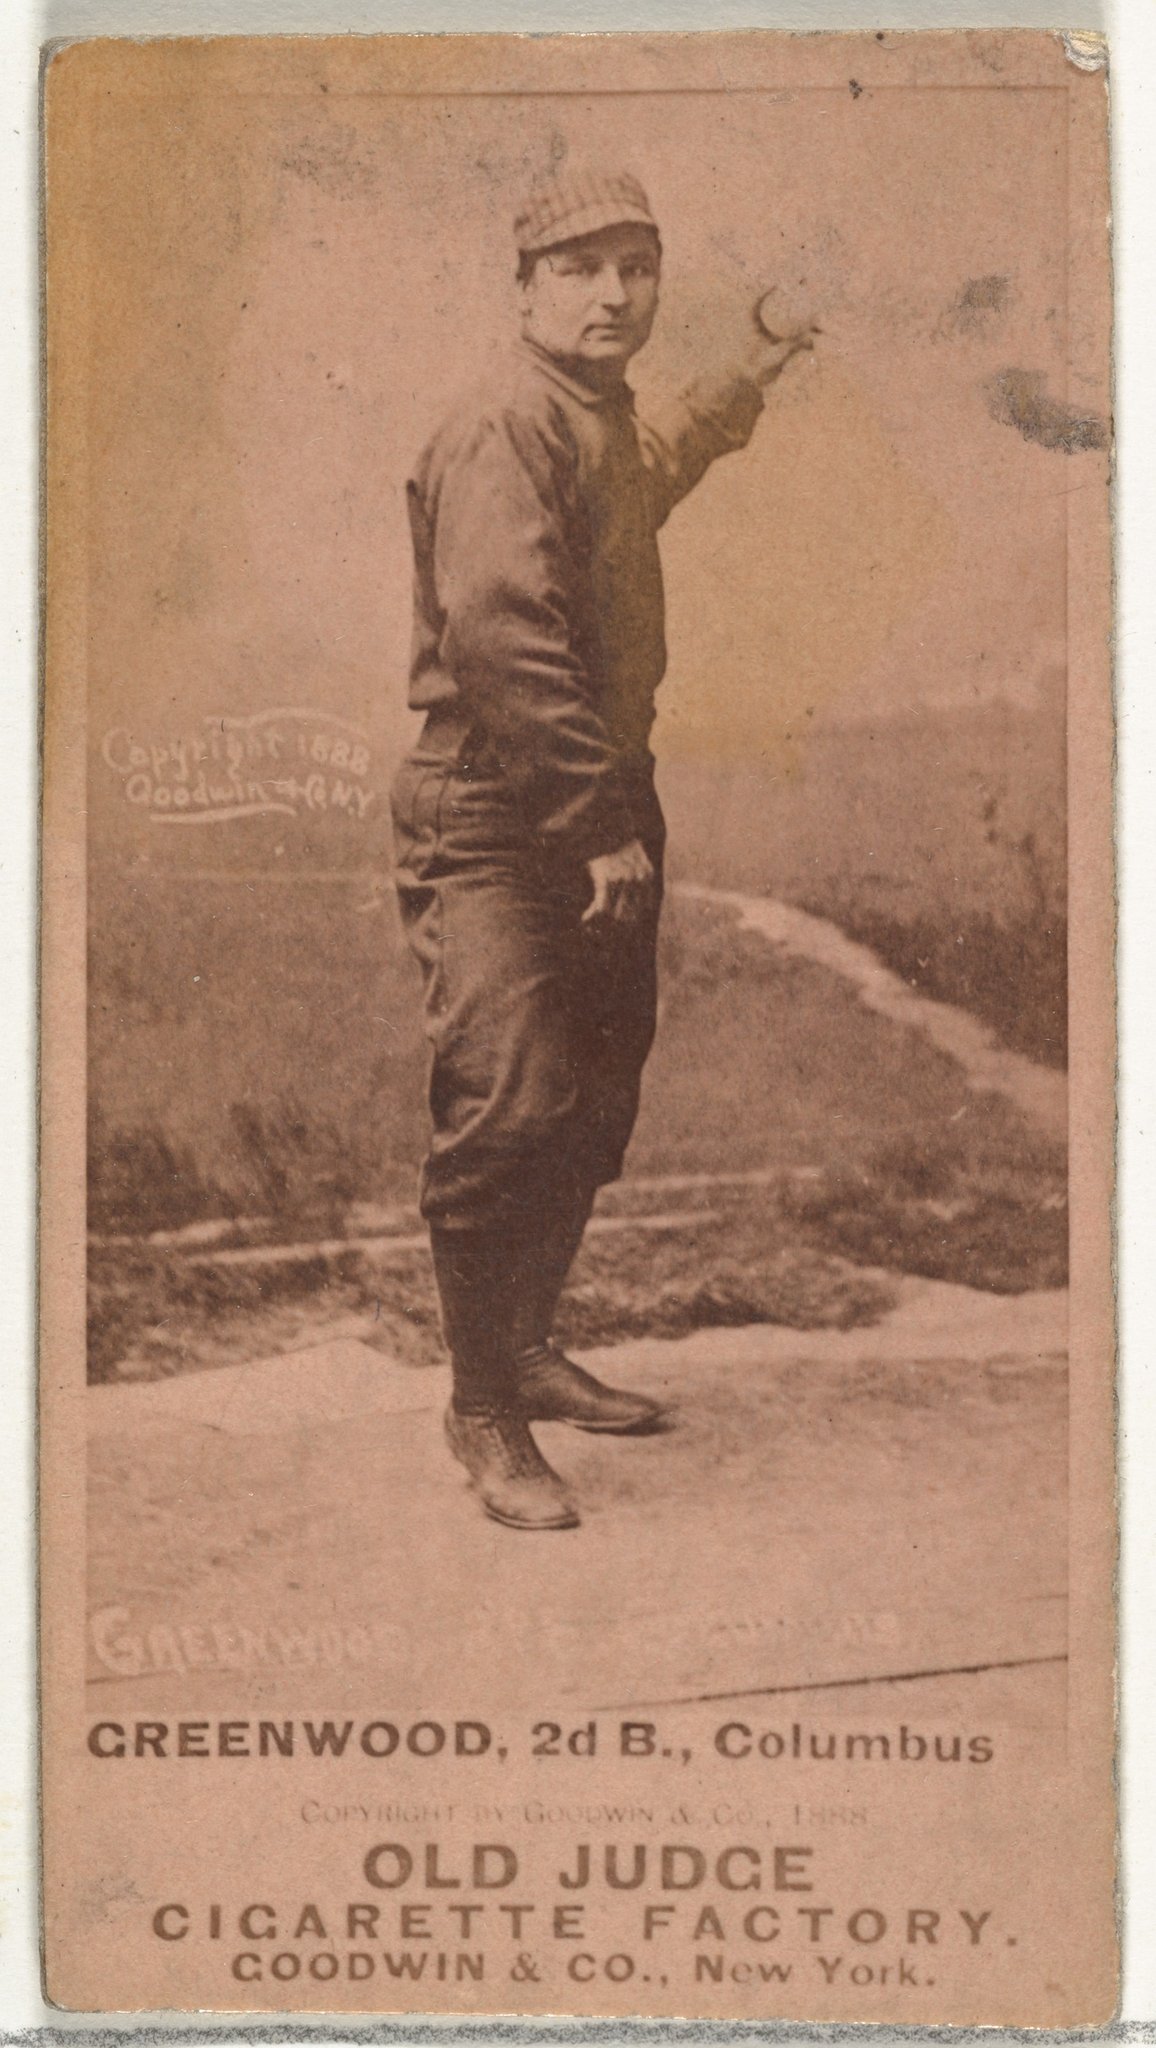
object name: baseball card, photograph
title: William F. "Bill" Greenwood, 2nd Base, Cleveland, from the Old Judge series (N172) for Old Judge Cigarettes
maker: goodwin & company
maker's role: publisher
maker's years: 1850-1950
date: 1888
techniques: albumen silver print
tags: men,portraits,baseball,athletes